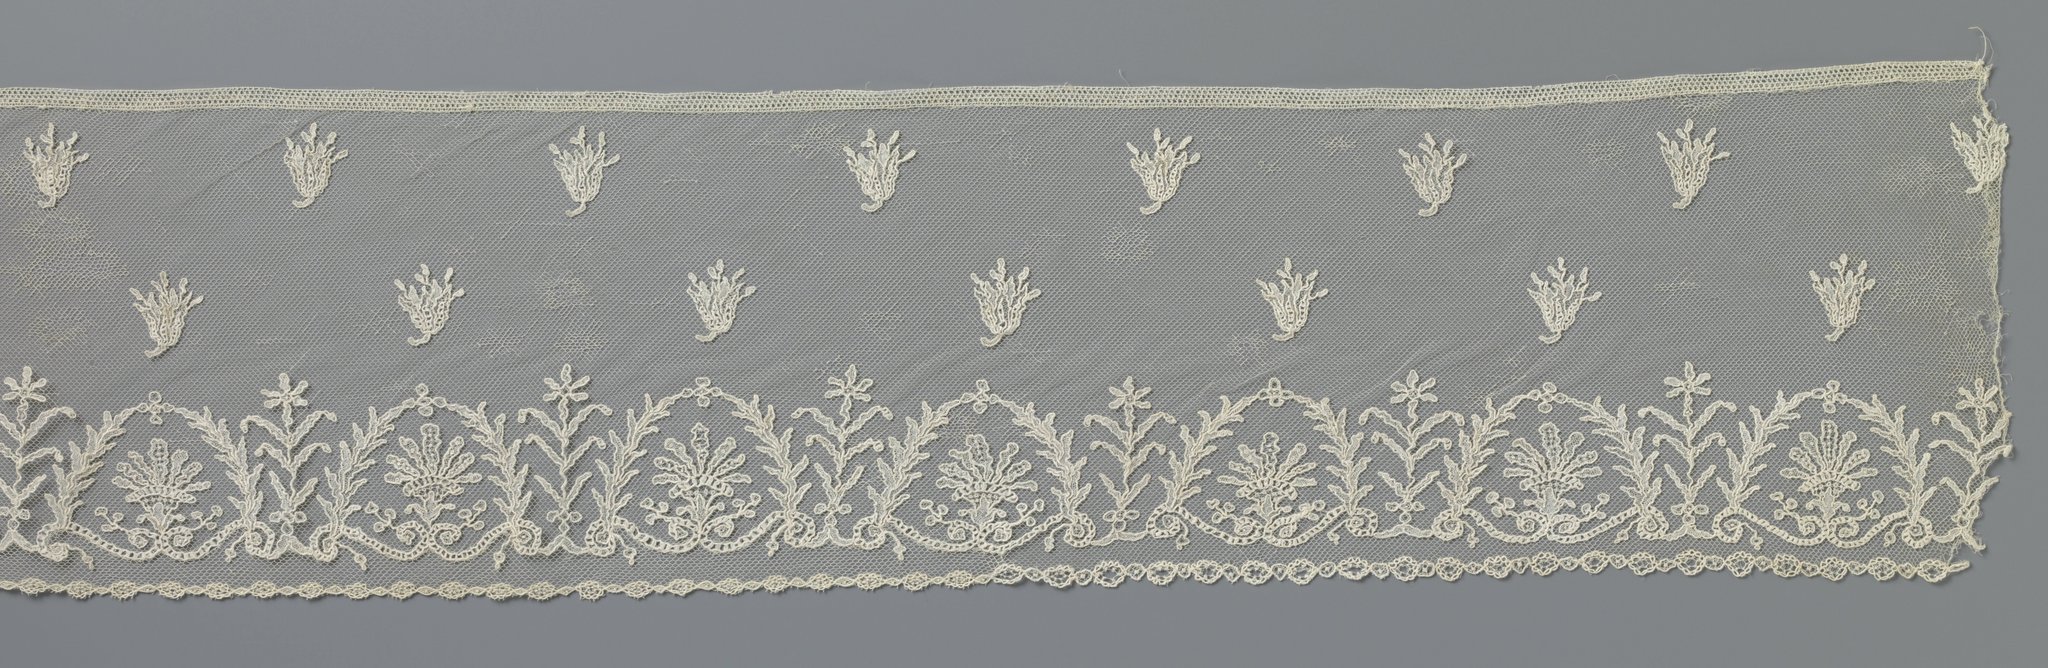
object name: strip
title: Japonstrook van applicatiekant met spitsboogrand en klokjes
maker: Anonymous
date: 1800-1809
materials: linen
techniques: lace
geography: brussels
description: Japonstrook naturelkleurige Brusselse applicatiekant: naaldkant geappliceerd op machinale tule. Dit type kant staat ook bekend onder de naam: point d'Angleterre. De buitenste, ornamentale rand bestaat uit palmetjes, onder spitsbogen, afgewisseld met een staand takje. De buitenkant is recht beëindigd door een oogjeslijstje. Een strooipatroon van hangende klokjesbloemen vult het fond boven de randen.